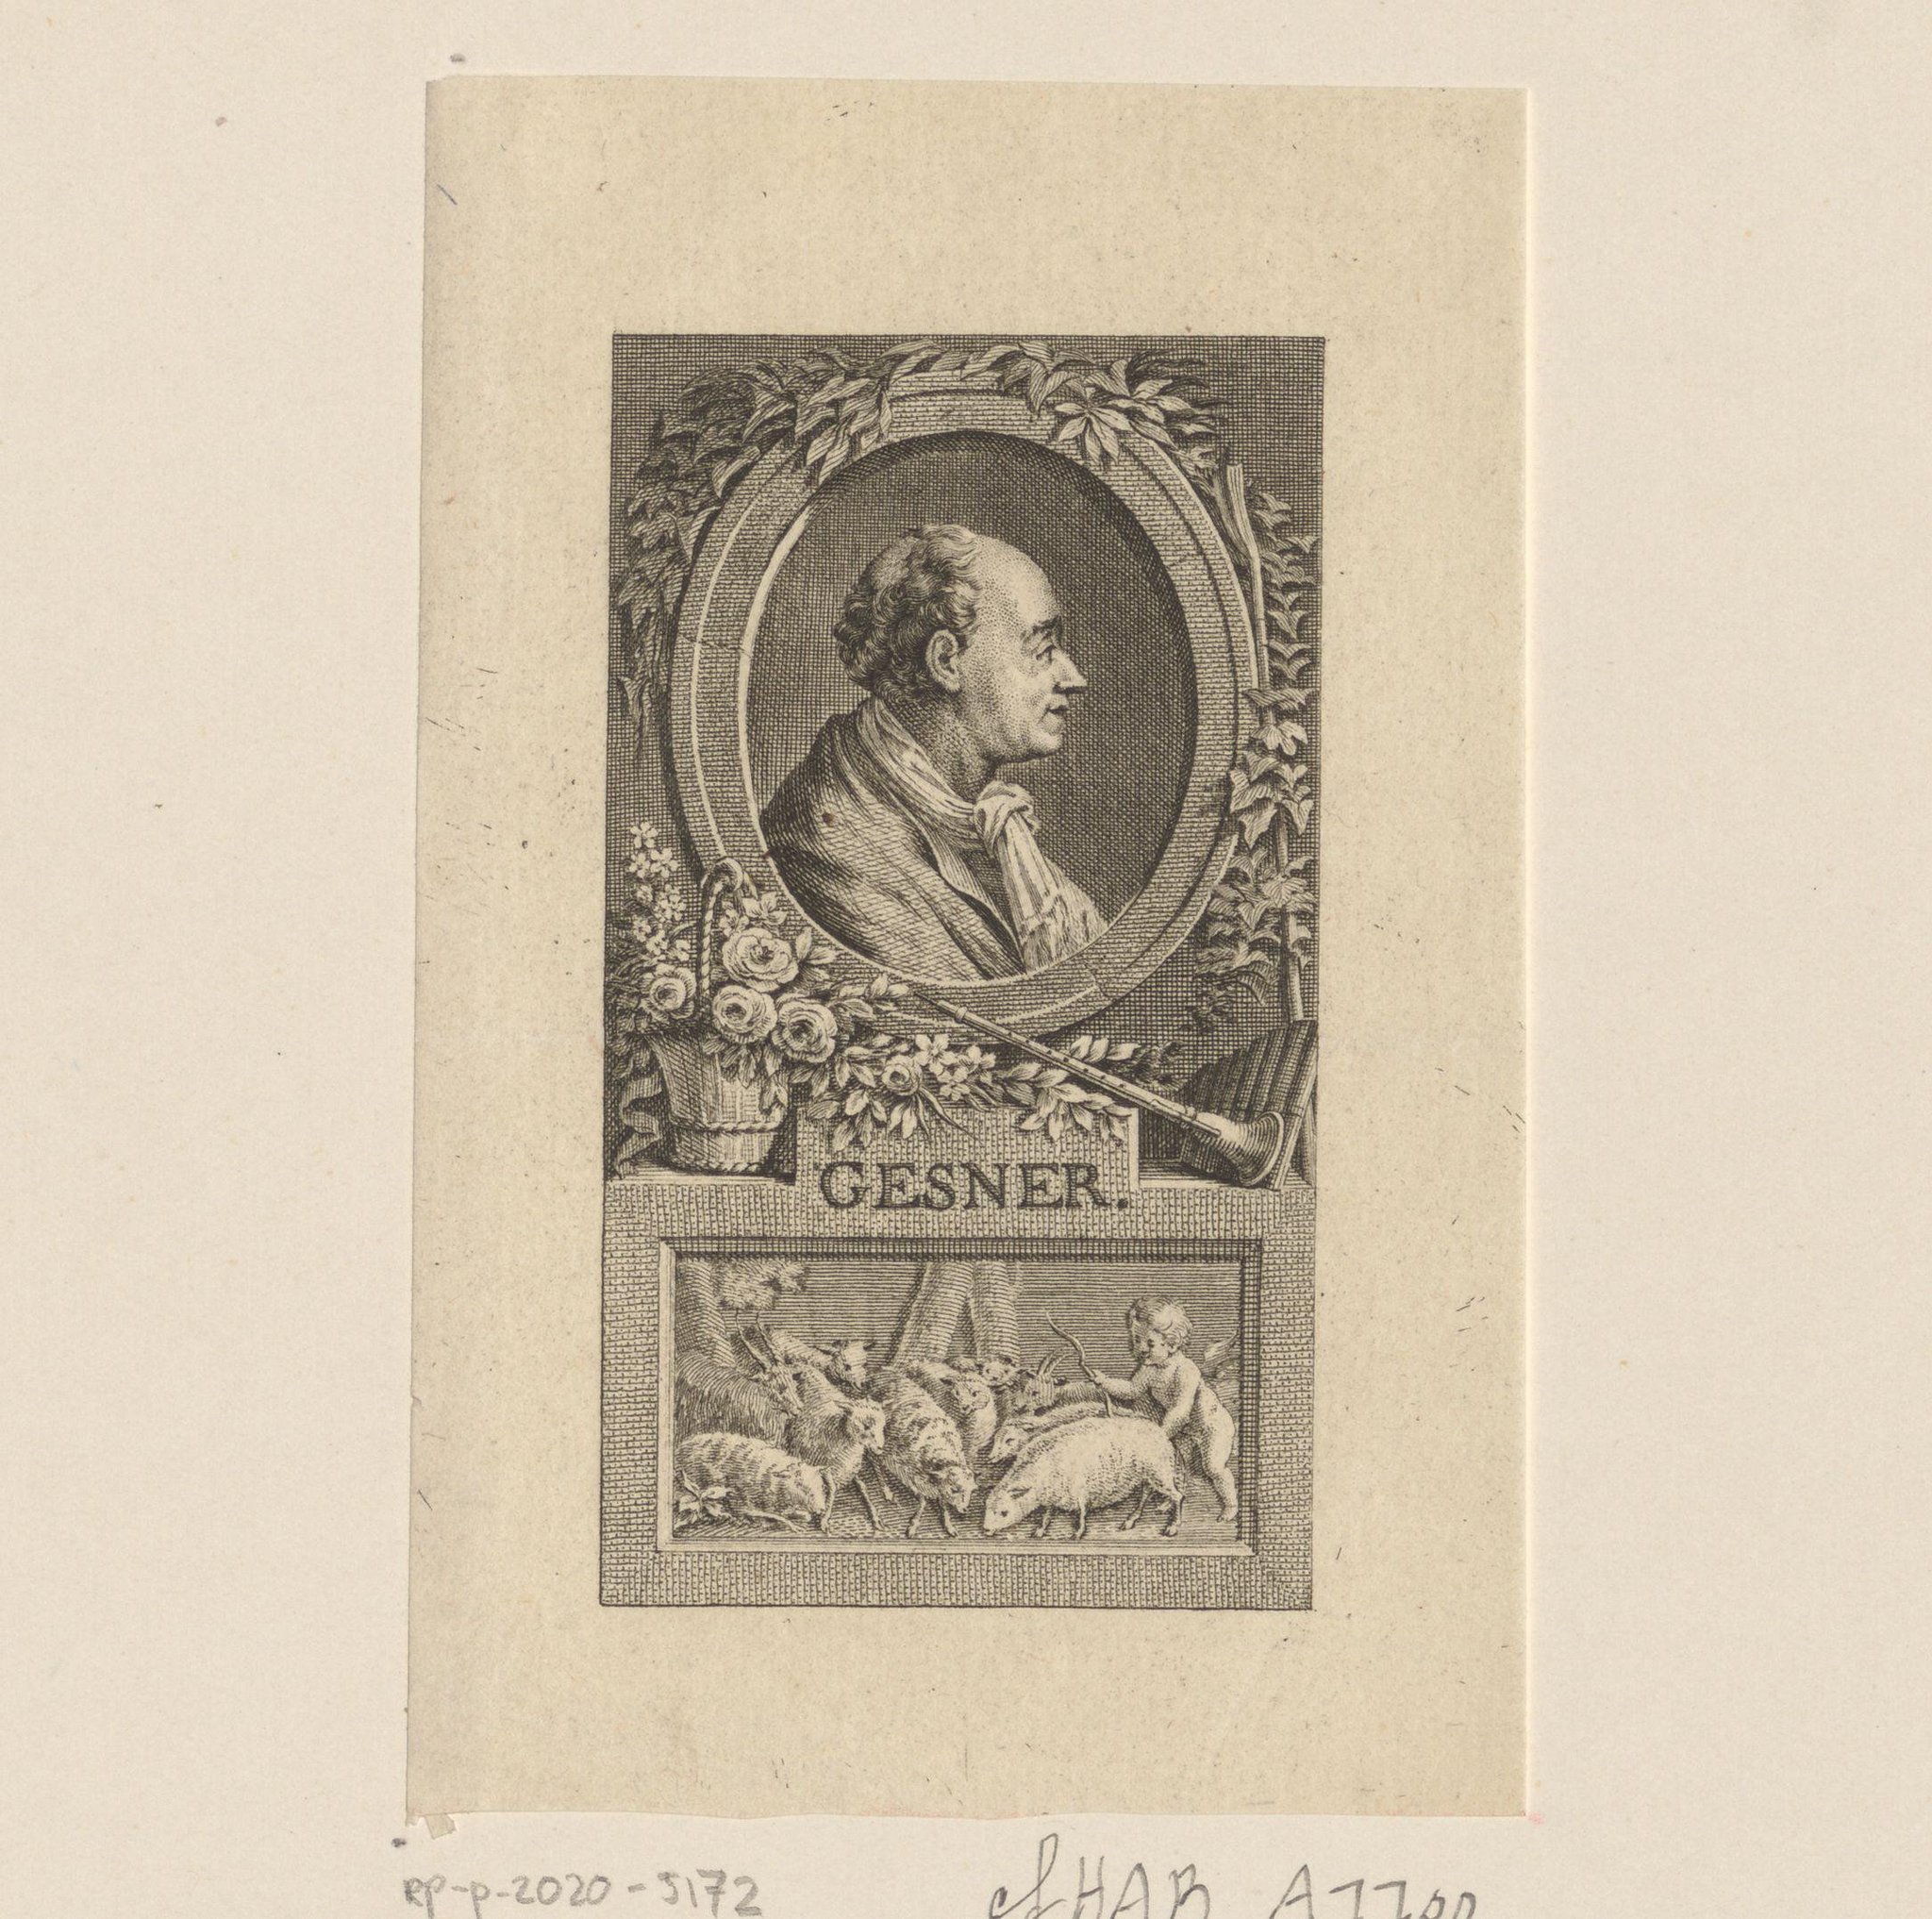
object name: print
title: Portret van Salomon Gessner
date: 1778-1850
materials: paper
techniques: engraving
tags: print maker, salomon gessner, historical persons, portrait, self-portrait of painter, writer, poet, author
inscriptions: number: ‘5’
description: In de marge een voorstelling van een putto met geiten en schapen.